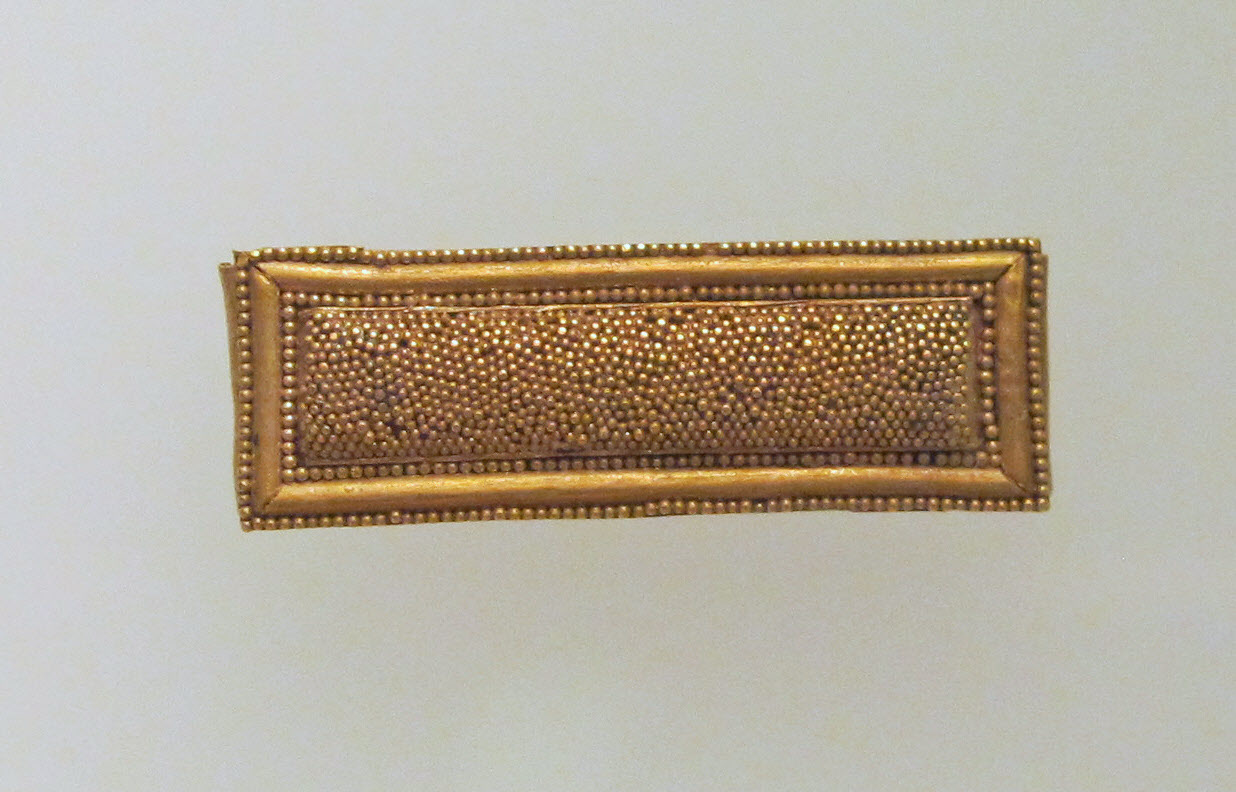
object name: bead, control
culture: cypriot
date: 3900 BCE-100 CE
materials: gold